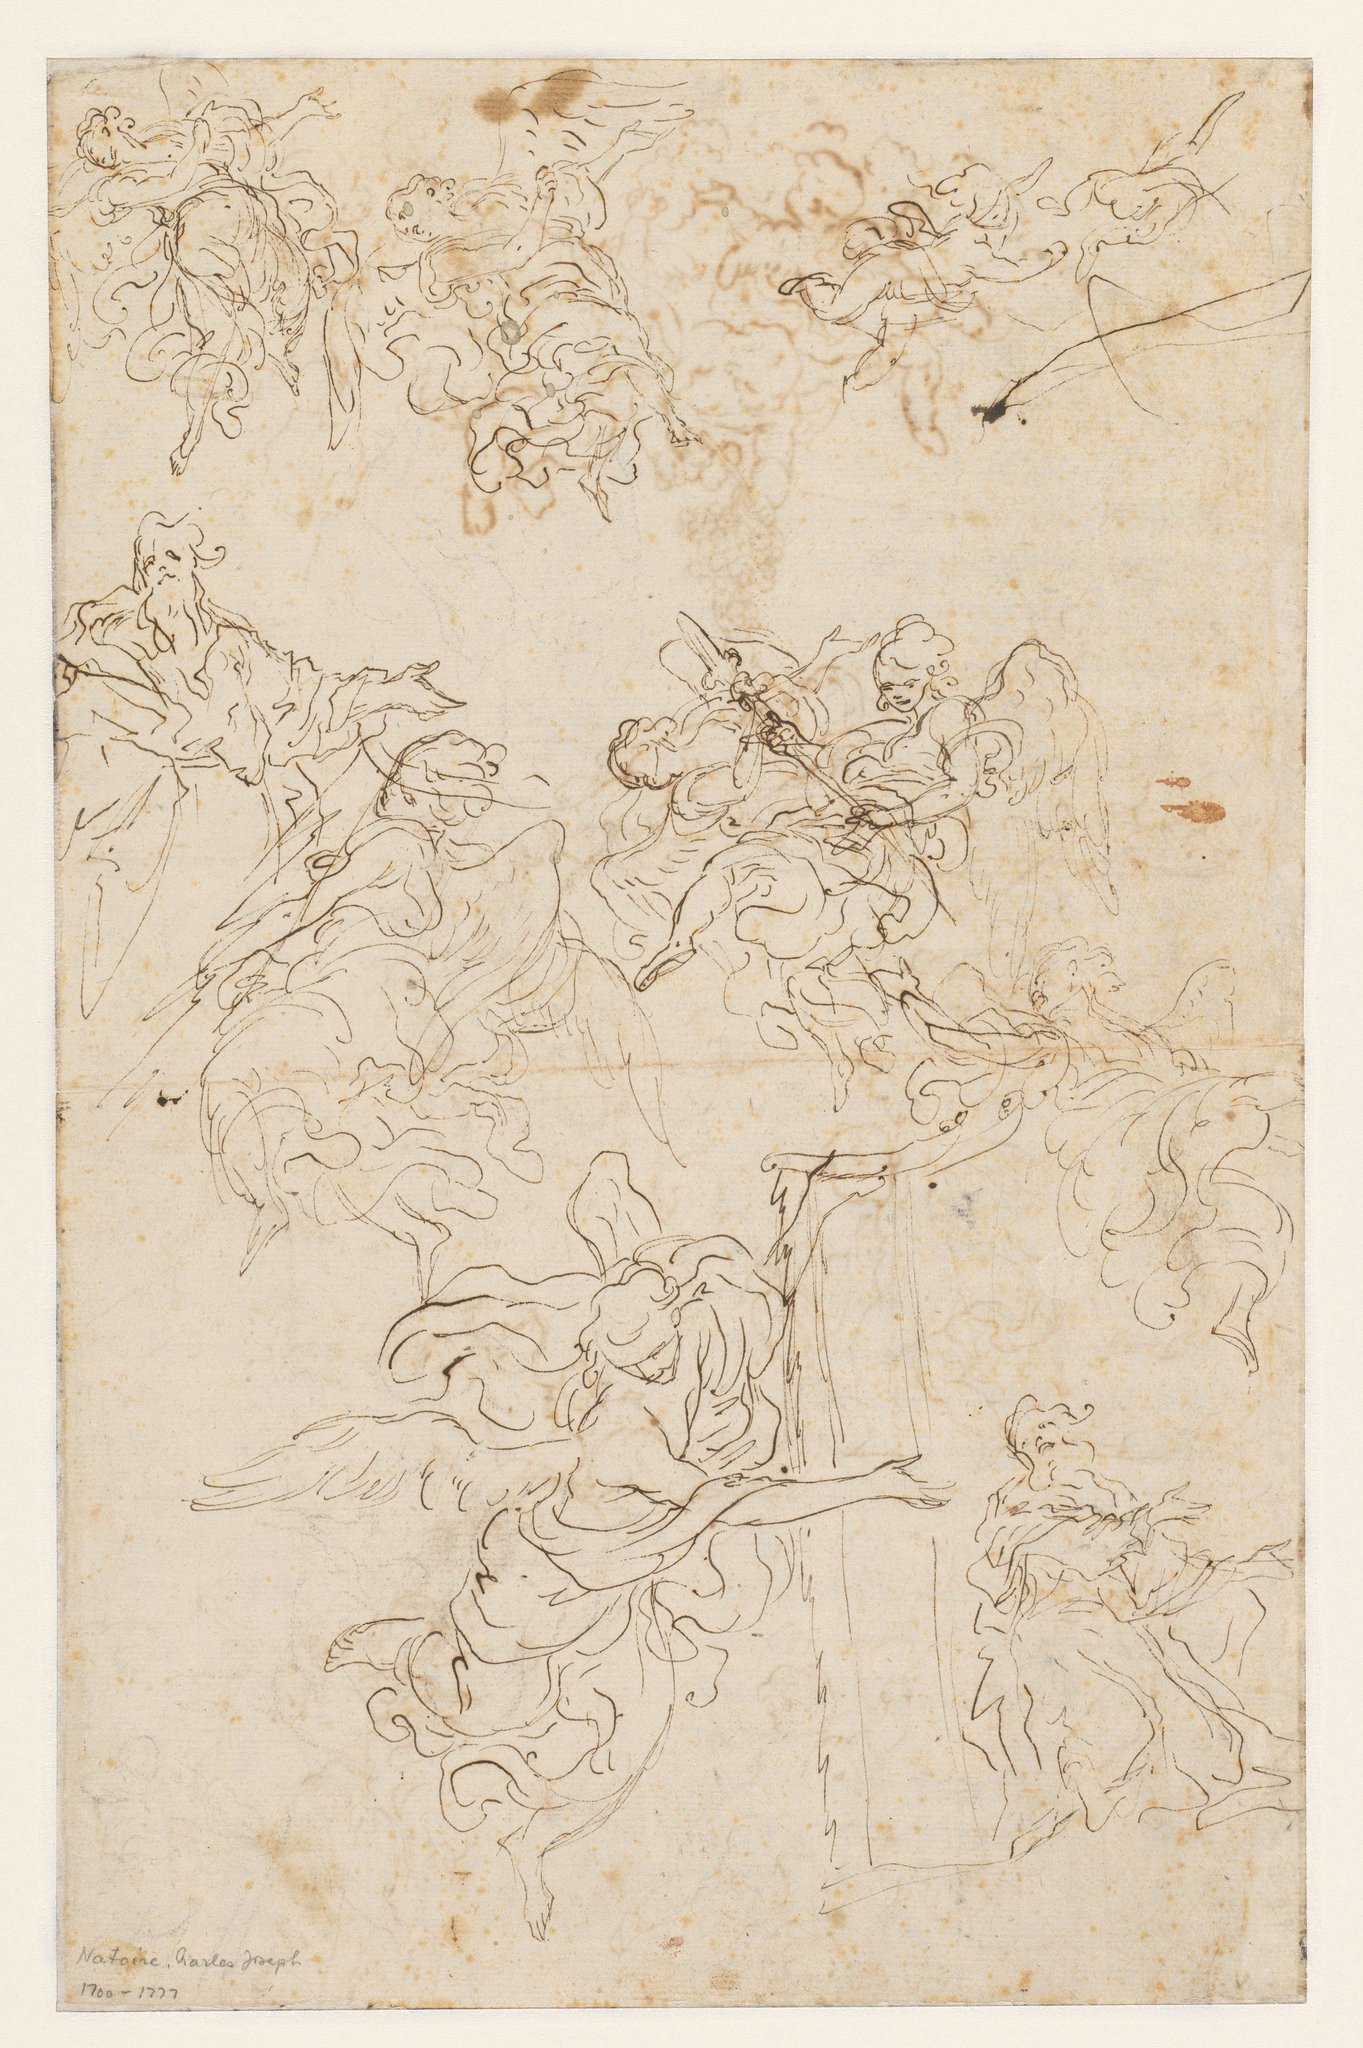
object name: drawing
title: Studies van een heilige en van engelen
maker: charles joseph natoire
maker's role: draughtsman, print maker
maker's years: 1700-1777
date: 1710-1777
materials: paper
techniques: pen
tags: saints, angels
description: Schetsblad met studies van een heilige en van engelen, onder meer met passie-attributen.